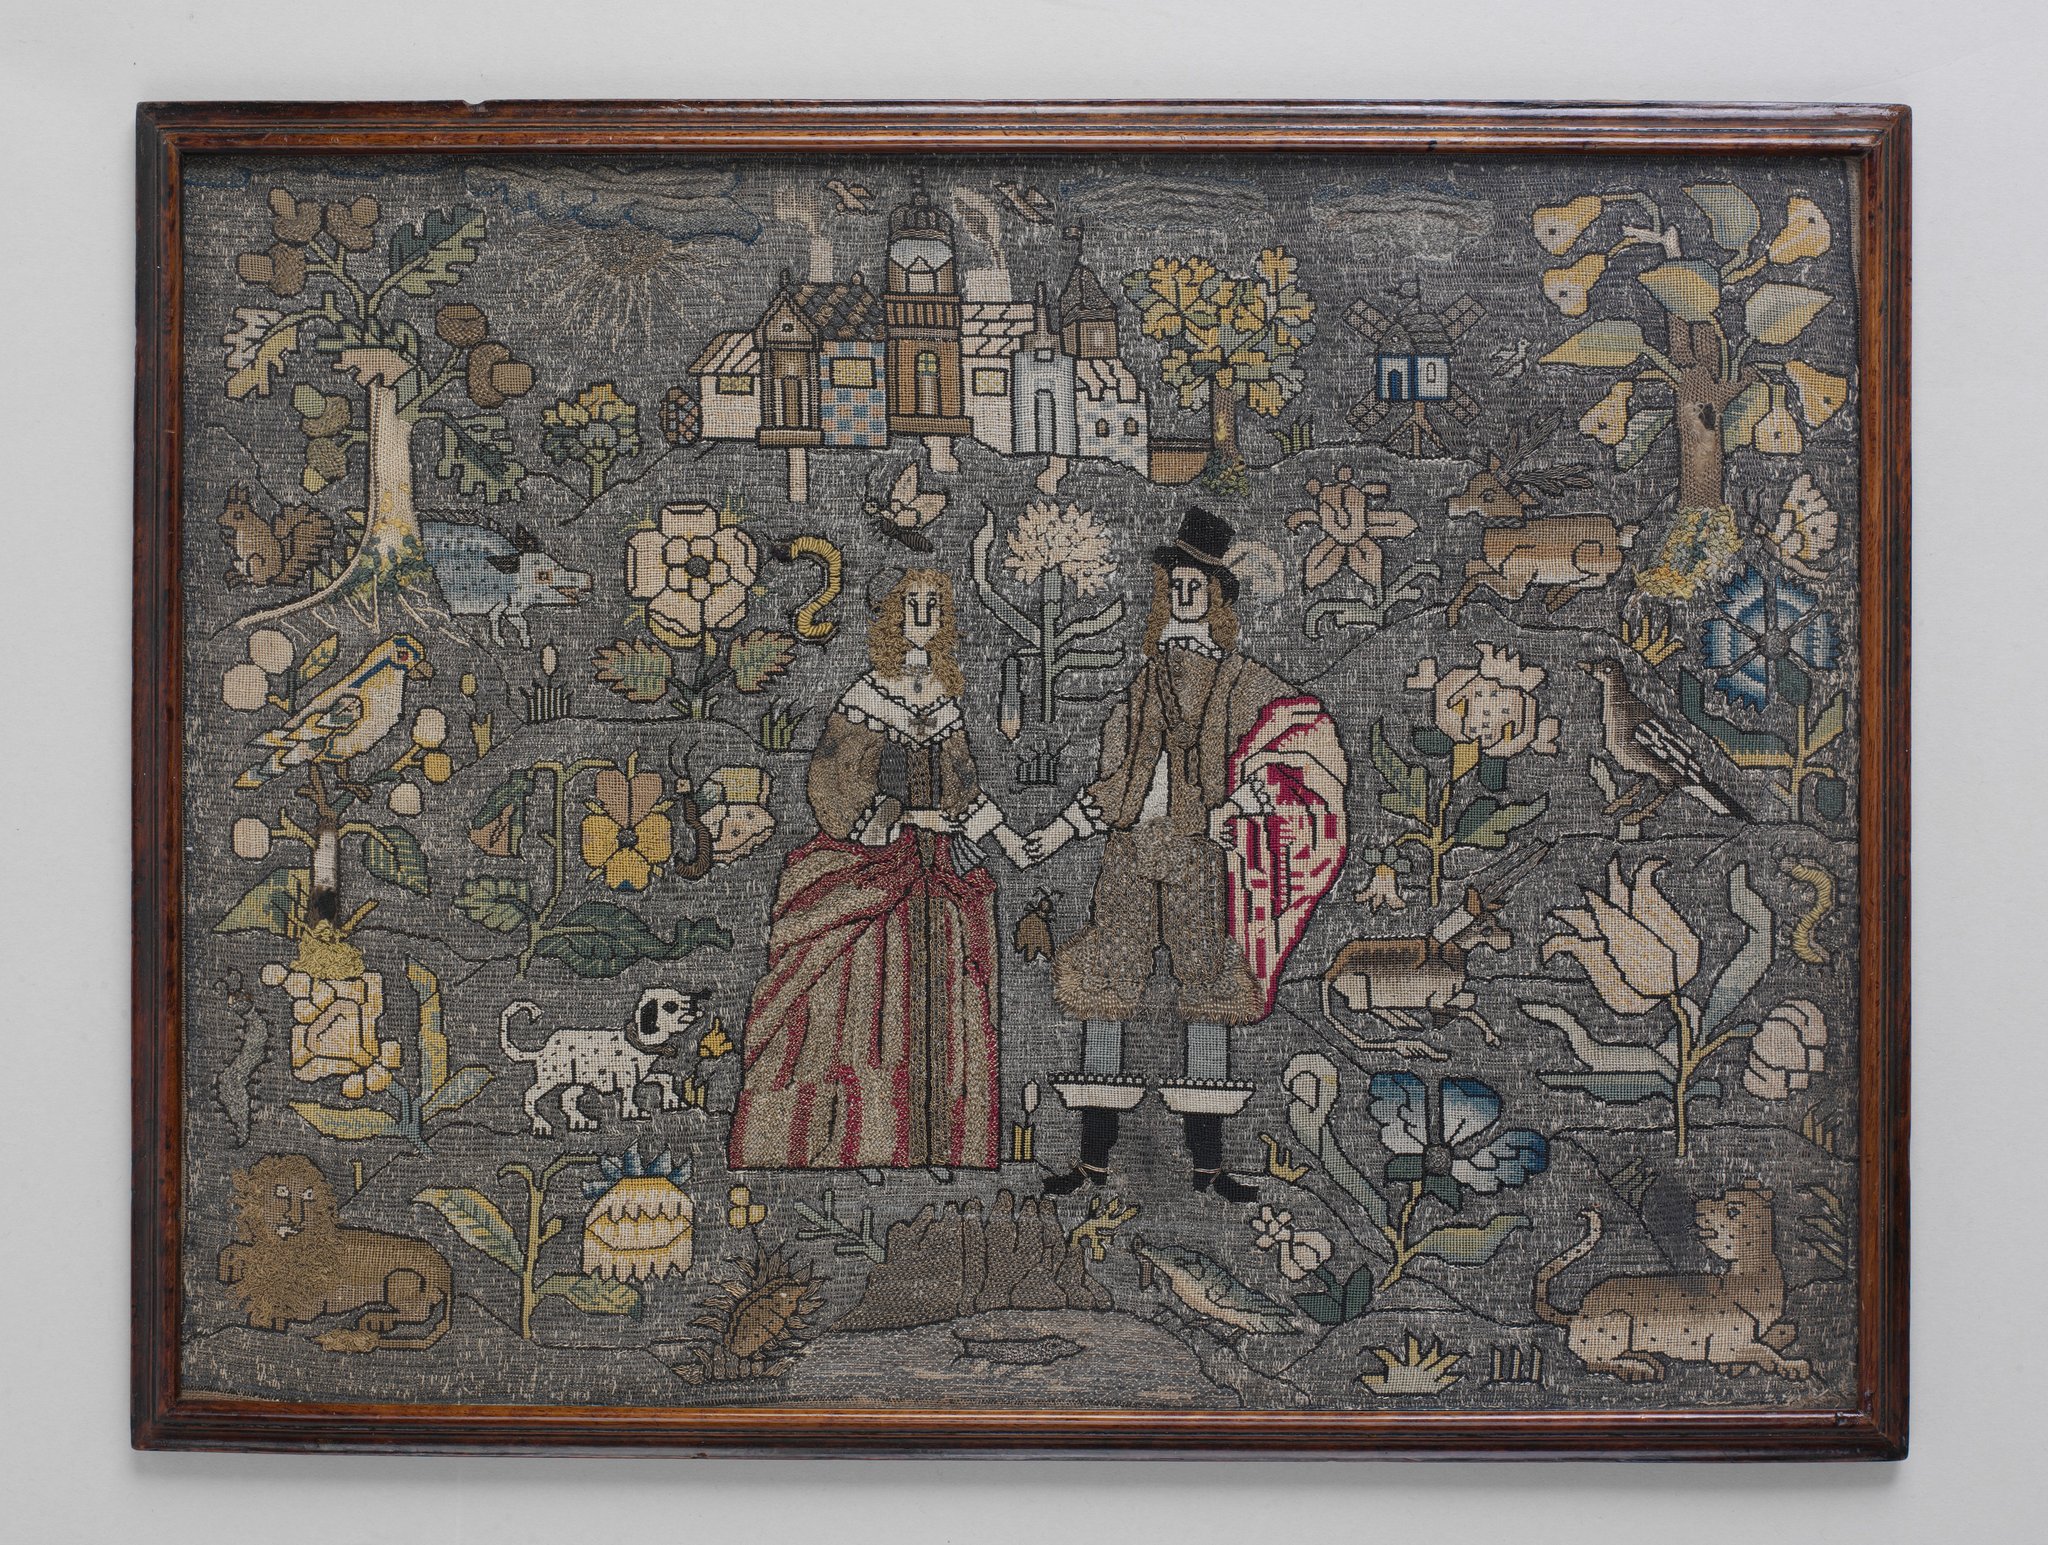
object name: embroidered picture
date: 1634-1666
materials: canvas, metal thread, silk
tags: houses,men,women,deer,dogs,insects,lions